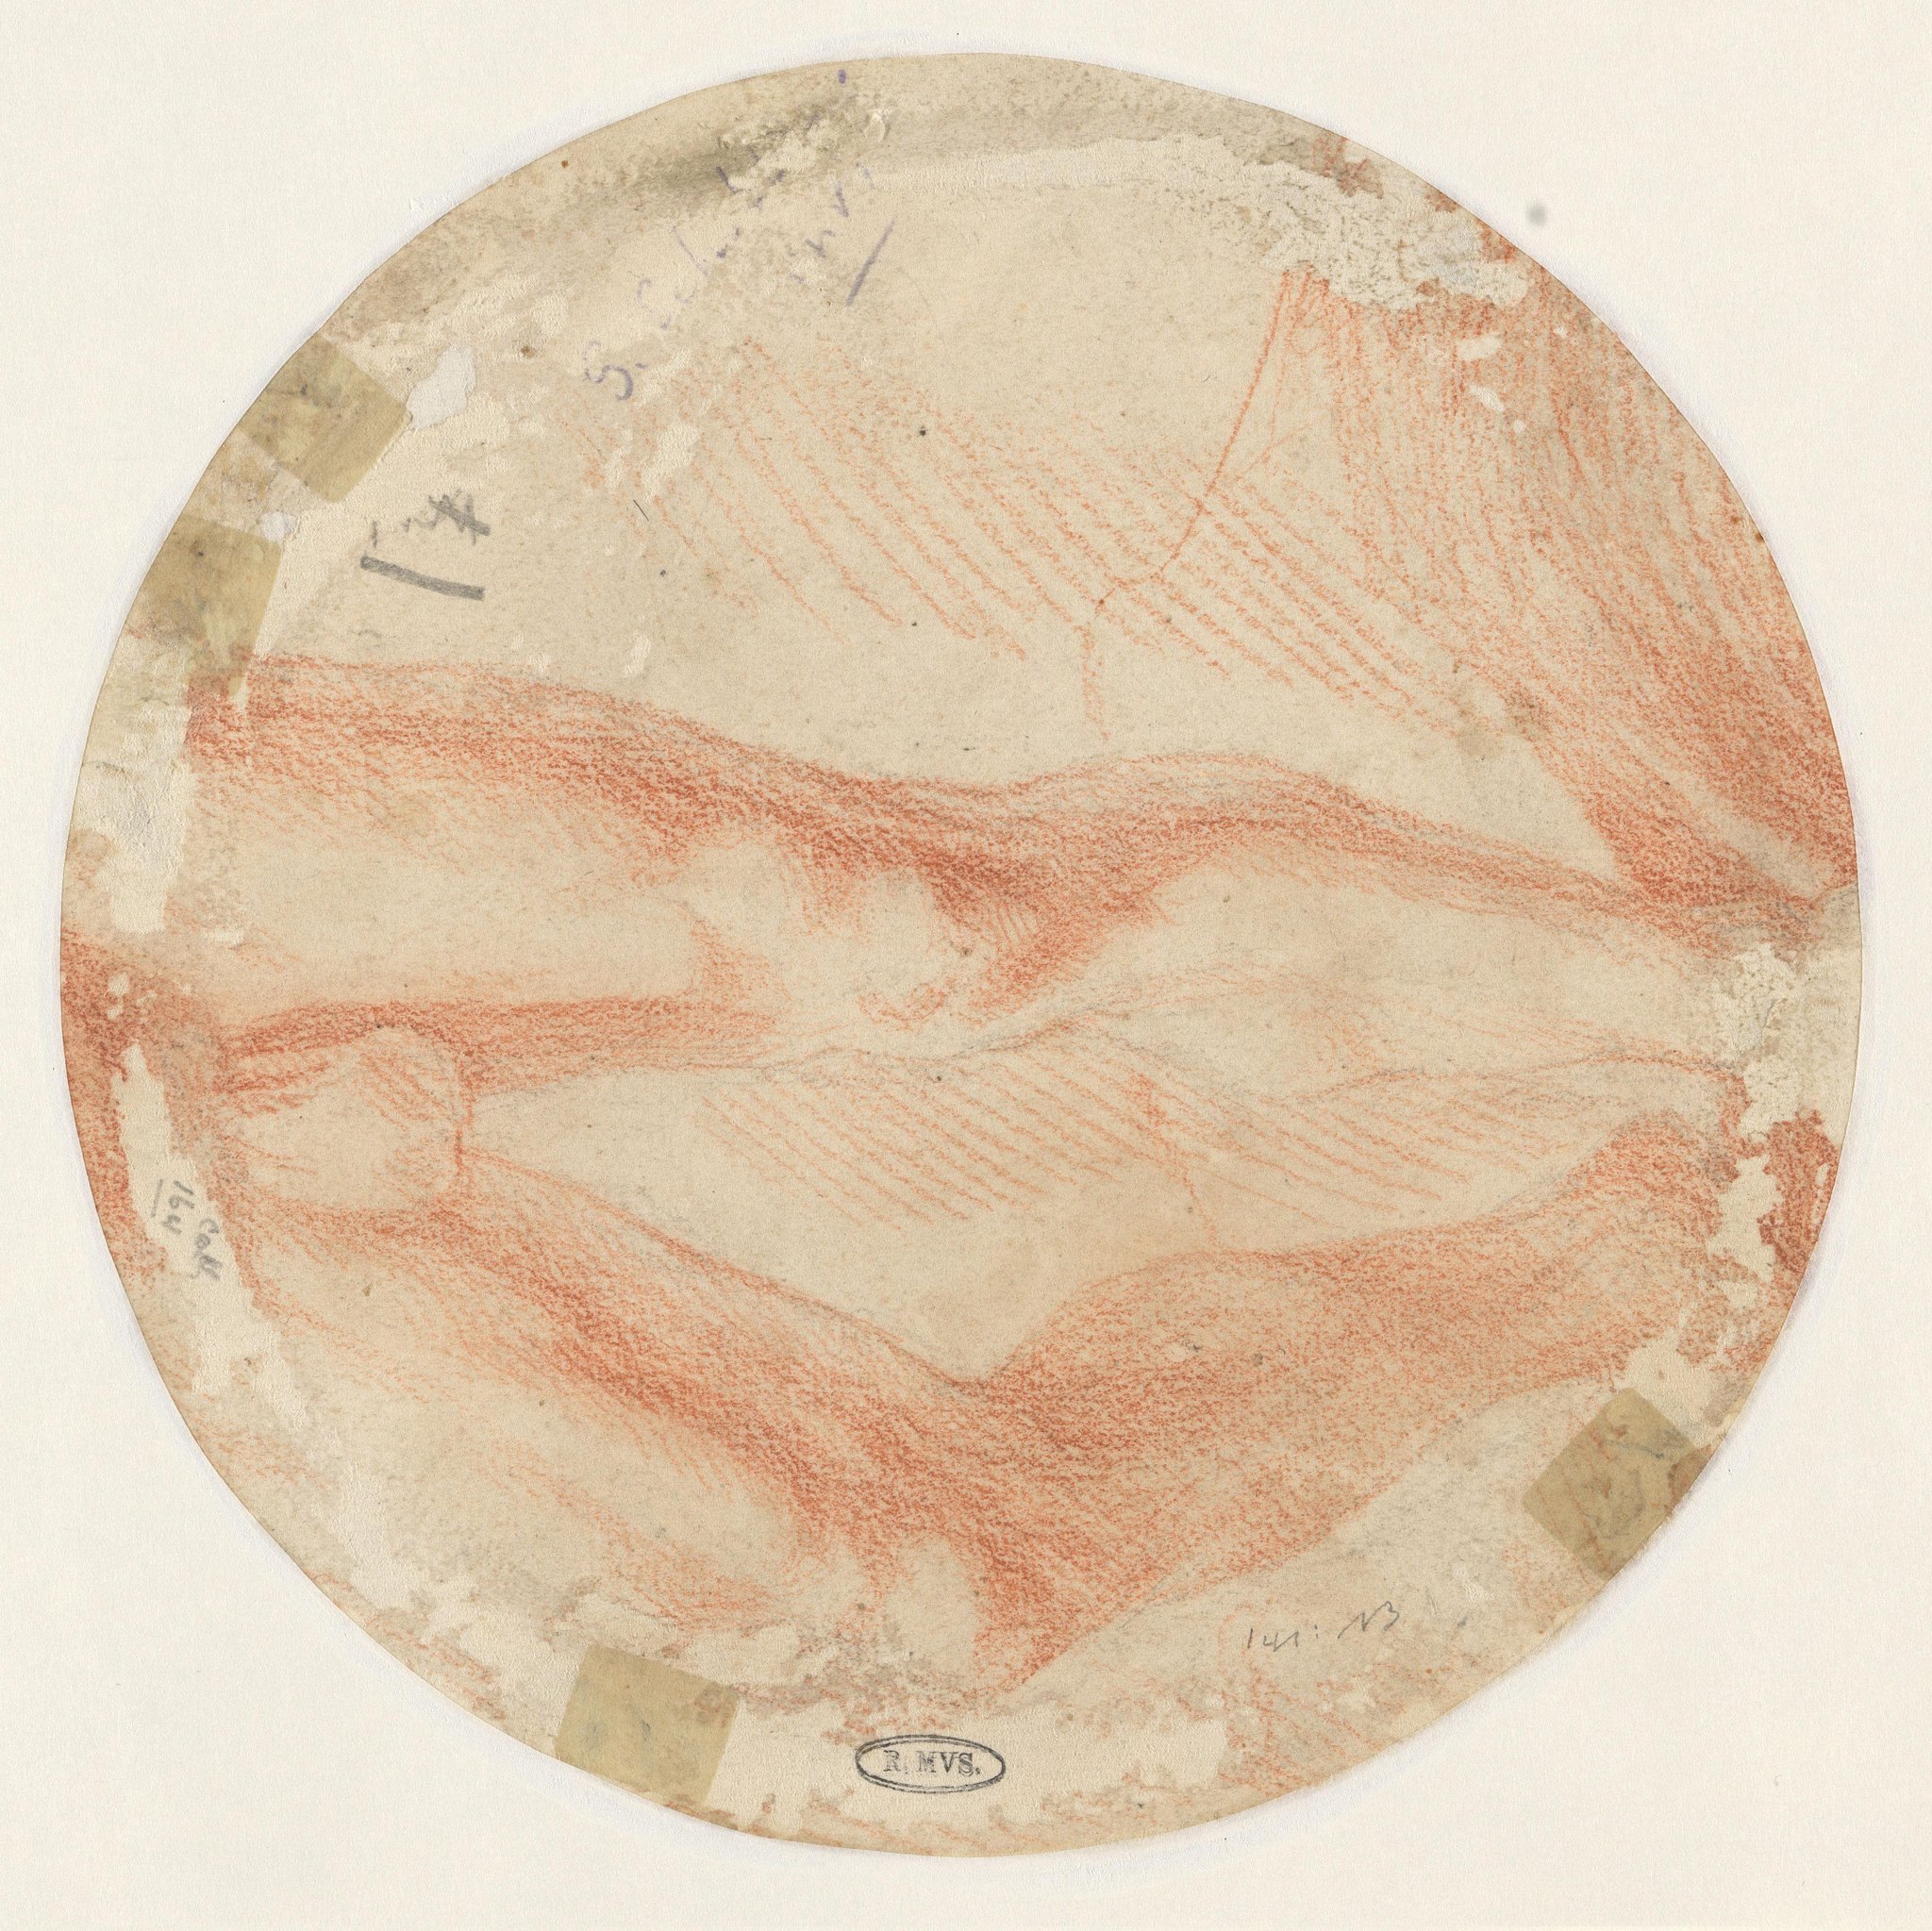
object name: drawing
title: Fragment van een studie van mannelijk naakt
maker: quellinus schobbens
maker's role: draughtsman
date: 1682-1711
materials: chalk, paper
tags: legs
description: Fragment van een studie van een staand mannelijk naakt waarvan alleen een deel van de benen te zien zijn.